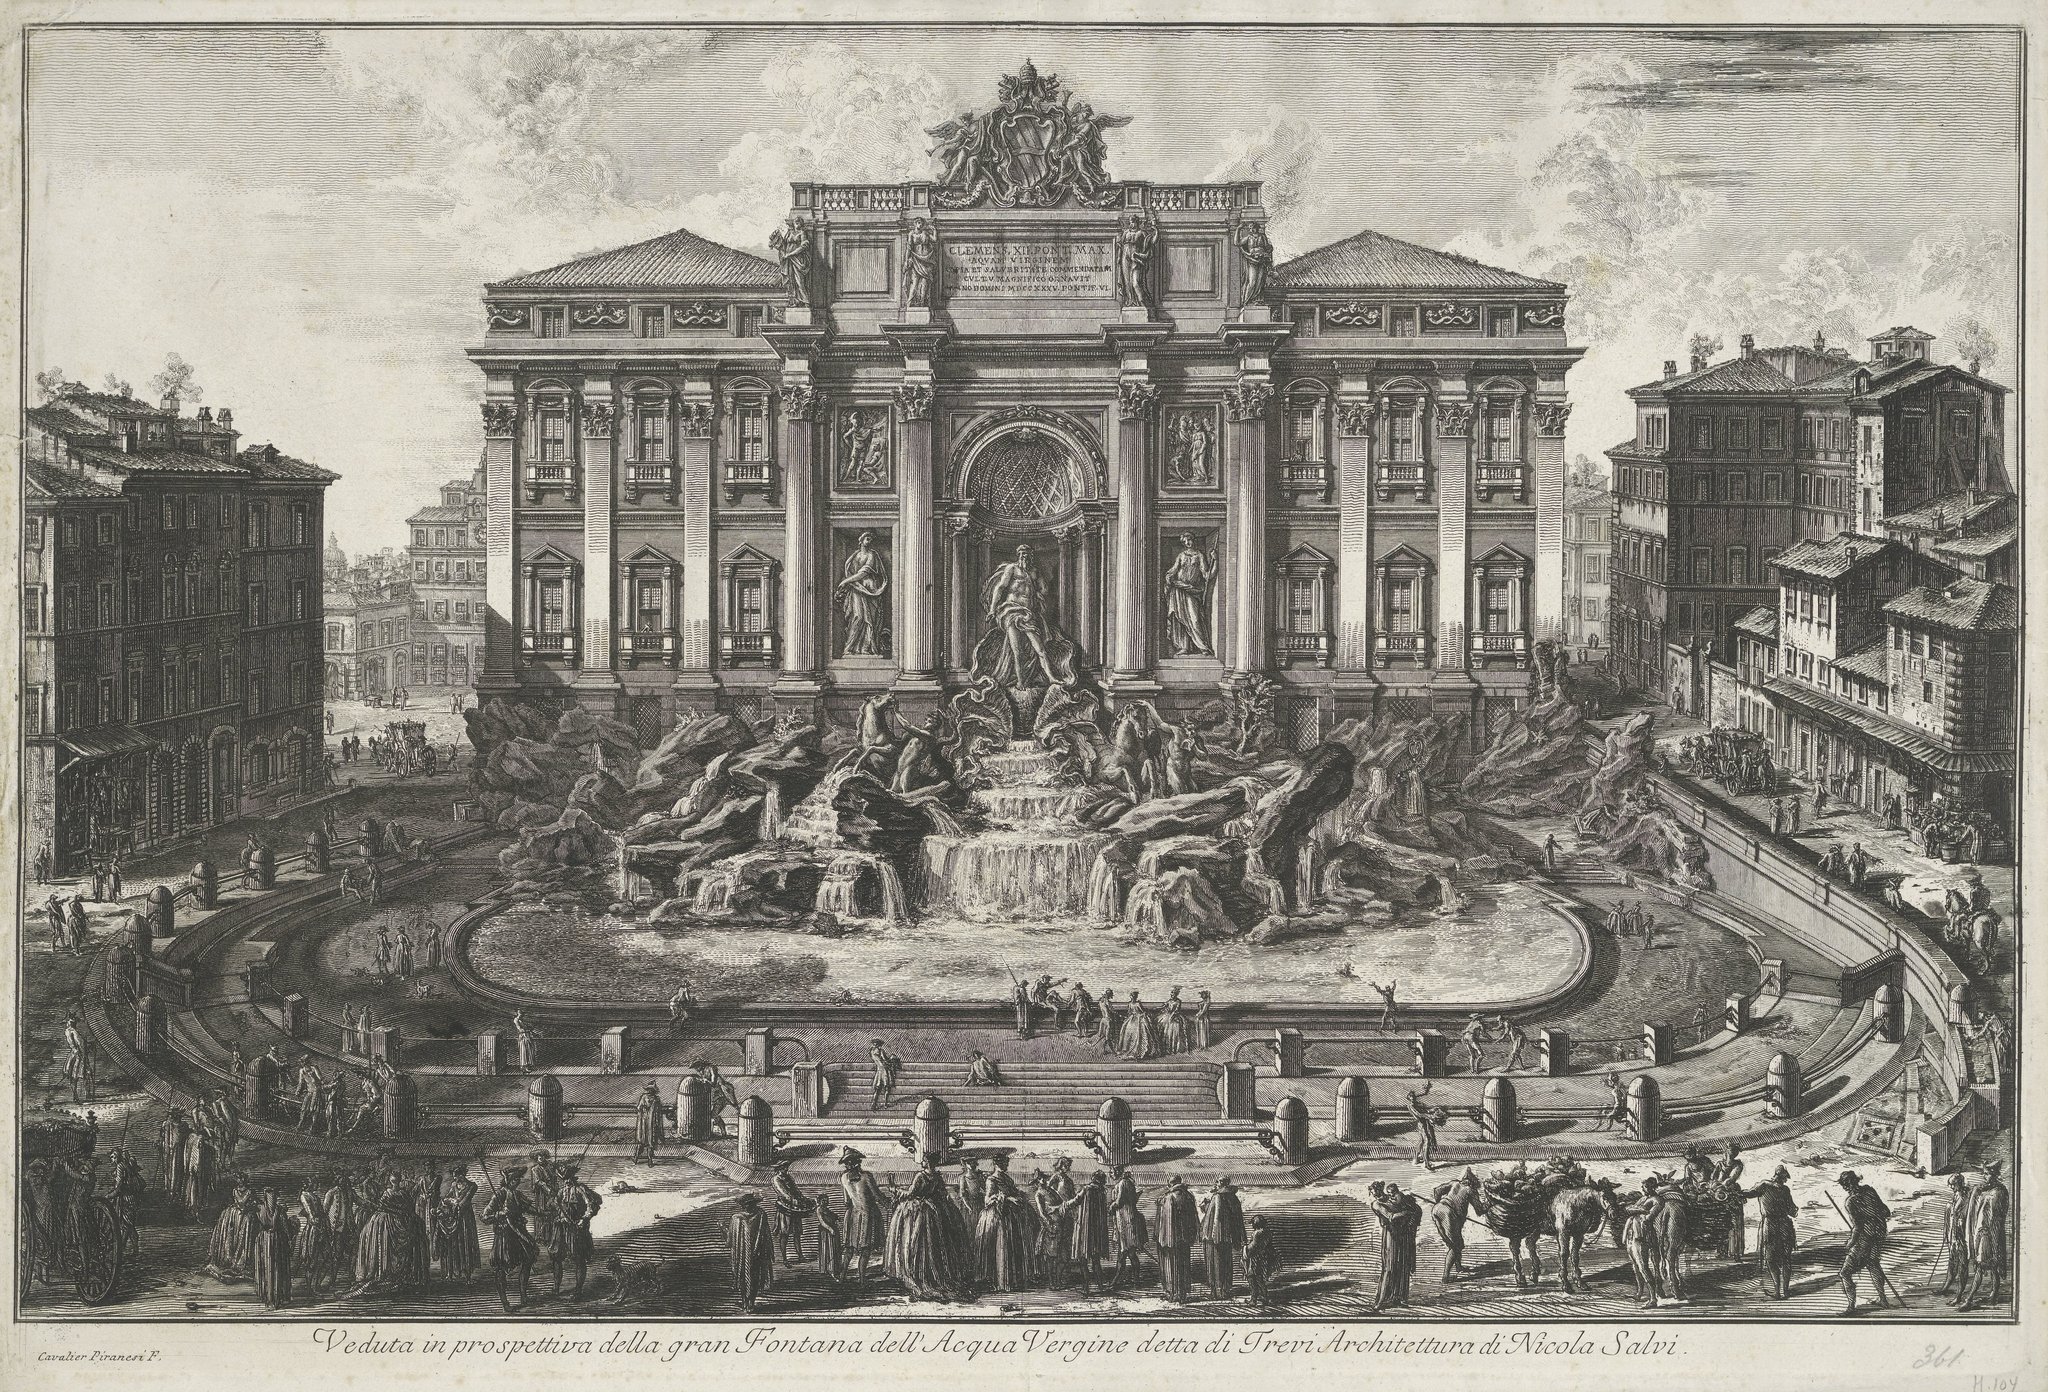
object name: print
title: Trevifontein te Rome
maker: giovanni battista piranesi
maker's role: designer, draughtsman, print maker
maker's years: 1720-1778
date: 1748-1778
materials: paper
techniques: etching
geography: rome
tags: piece of sculpture, reproduction of a piece of sculpture, ornamental fountain, rome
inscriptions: collector's mark: Lugt 2228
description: Deze prent maakt deel uit van de serie 'Vedute di Roma'. Piranesi werkte aan deze 135 platen tellende serie tussen 1748 en zijn dood in 1778. Francesco Piranesi voegde later nog twee prenten toe aan de reeks van zijn vader.